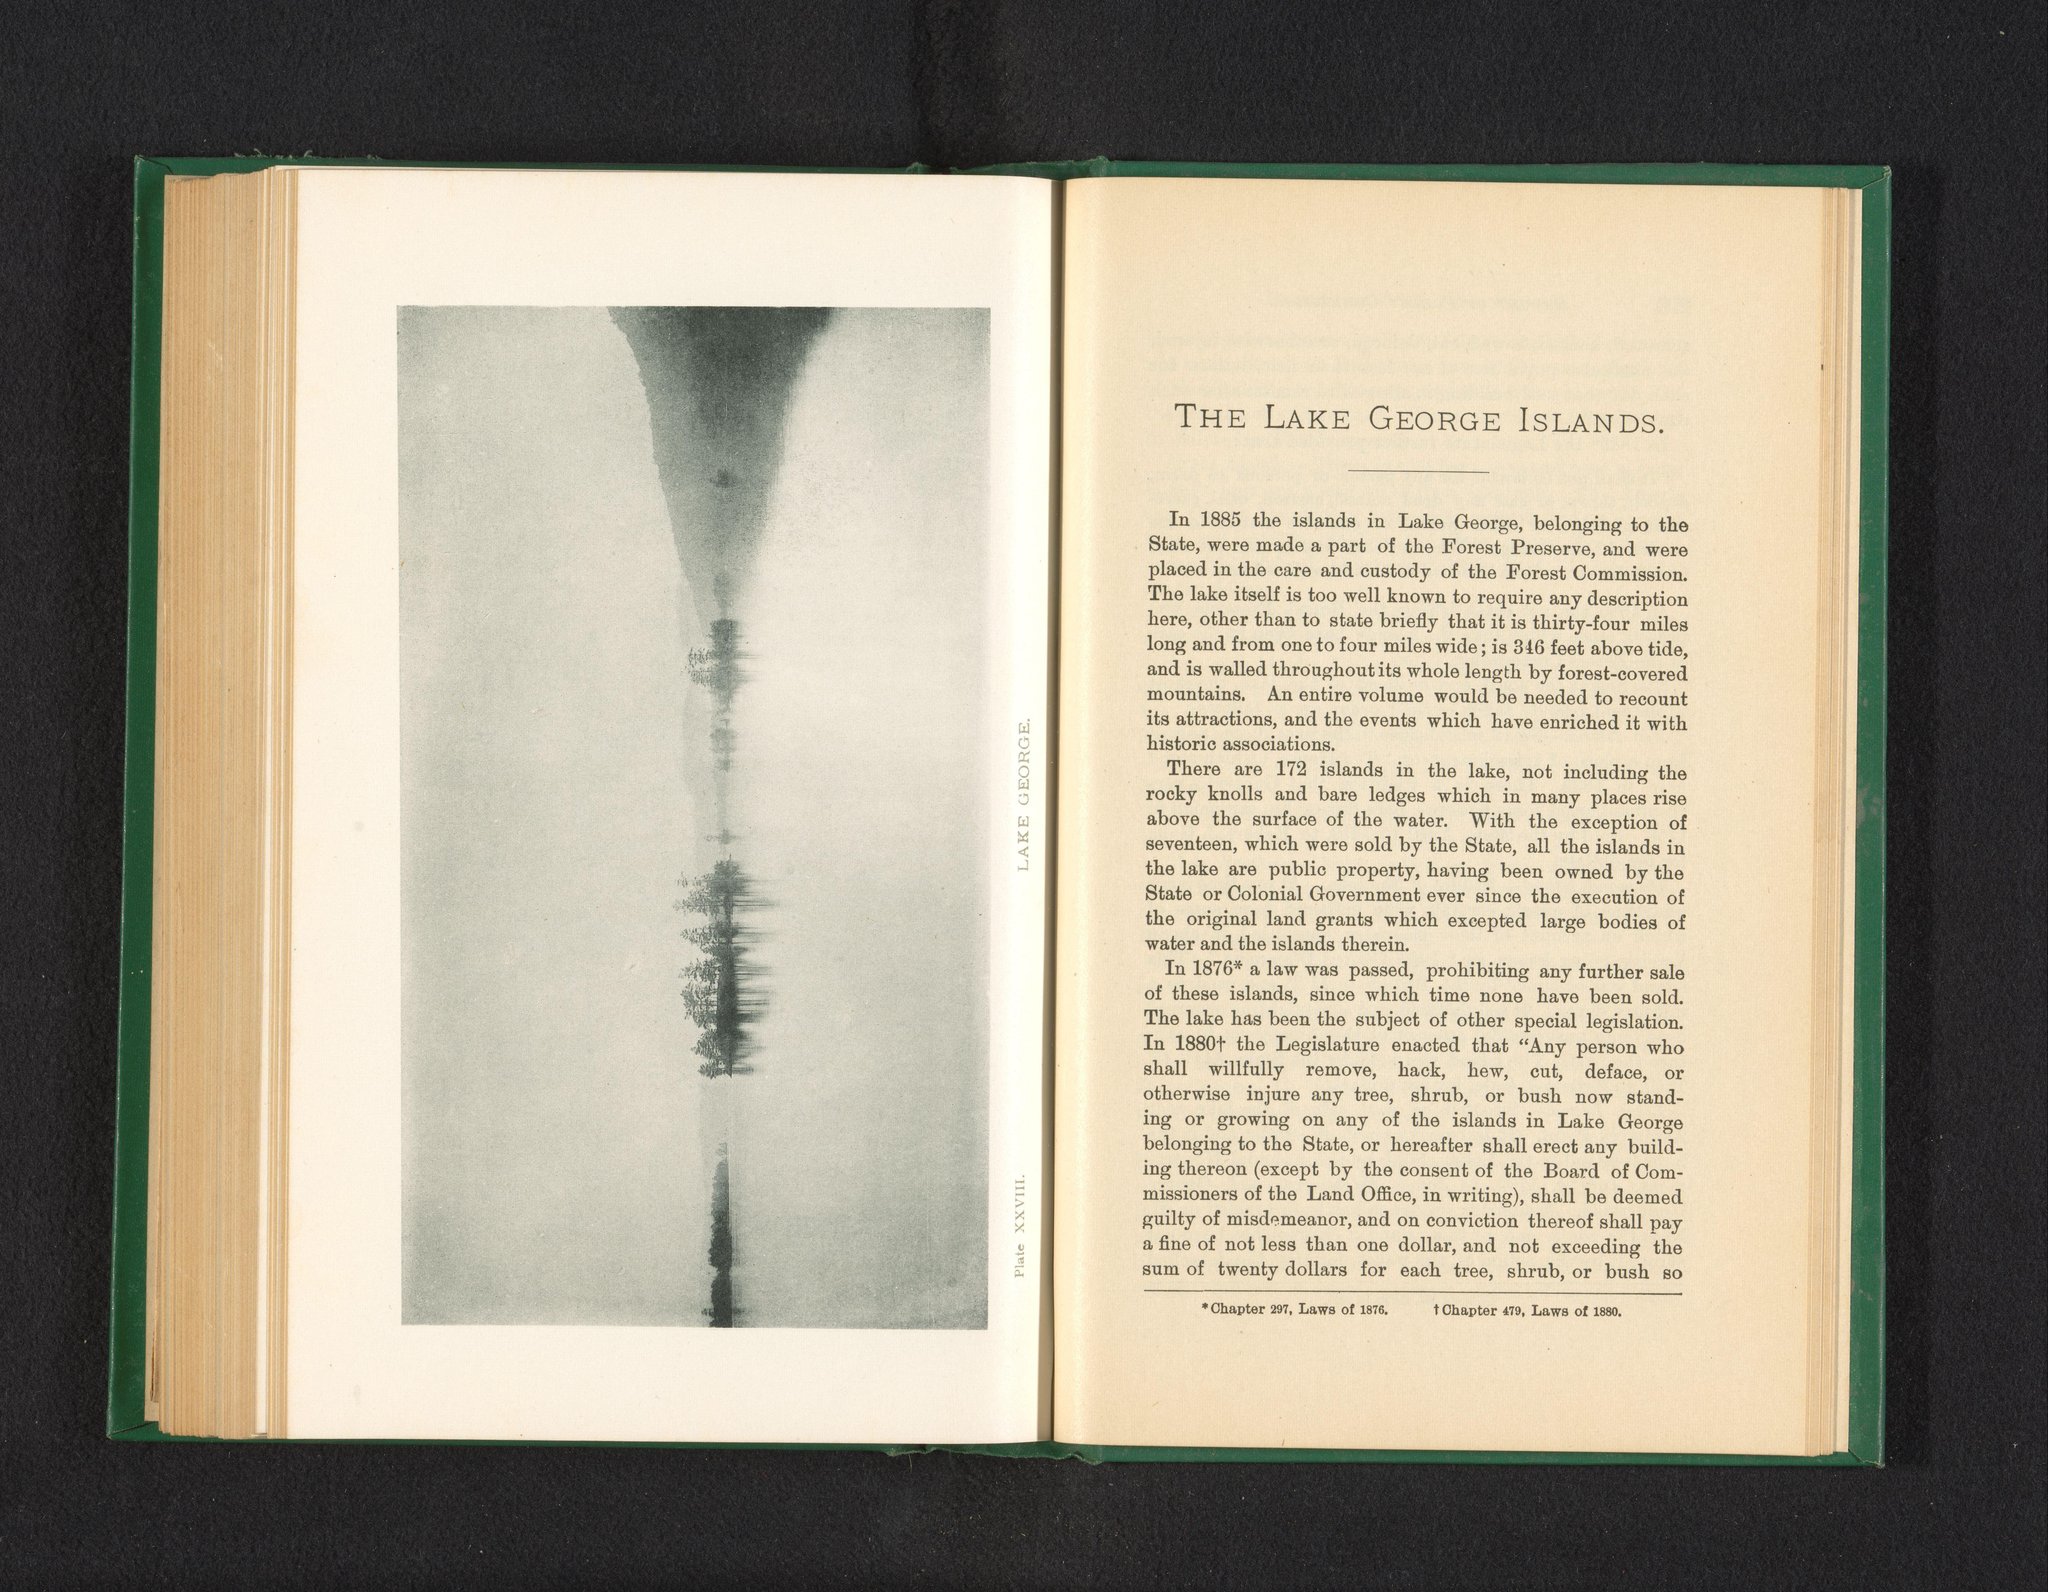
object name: page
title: Lake George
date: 1891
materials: paper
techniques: photograph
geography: new york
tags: lake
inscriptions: number: ‘Plate XXXIII.’